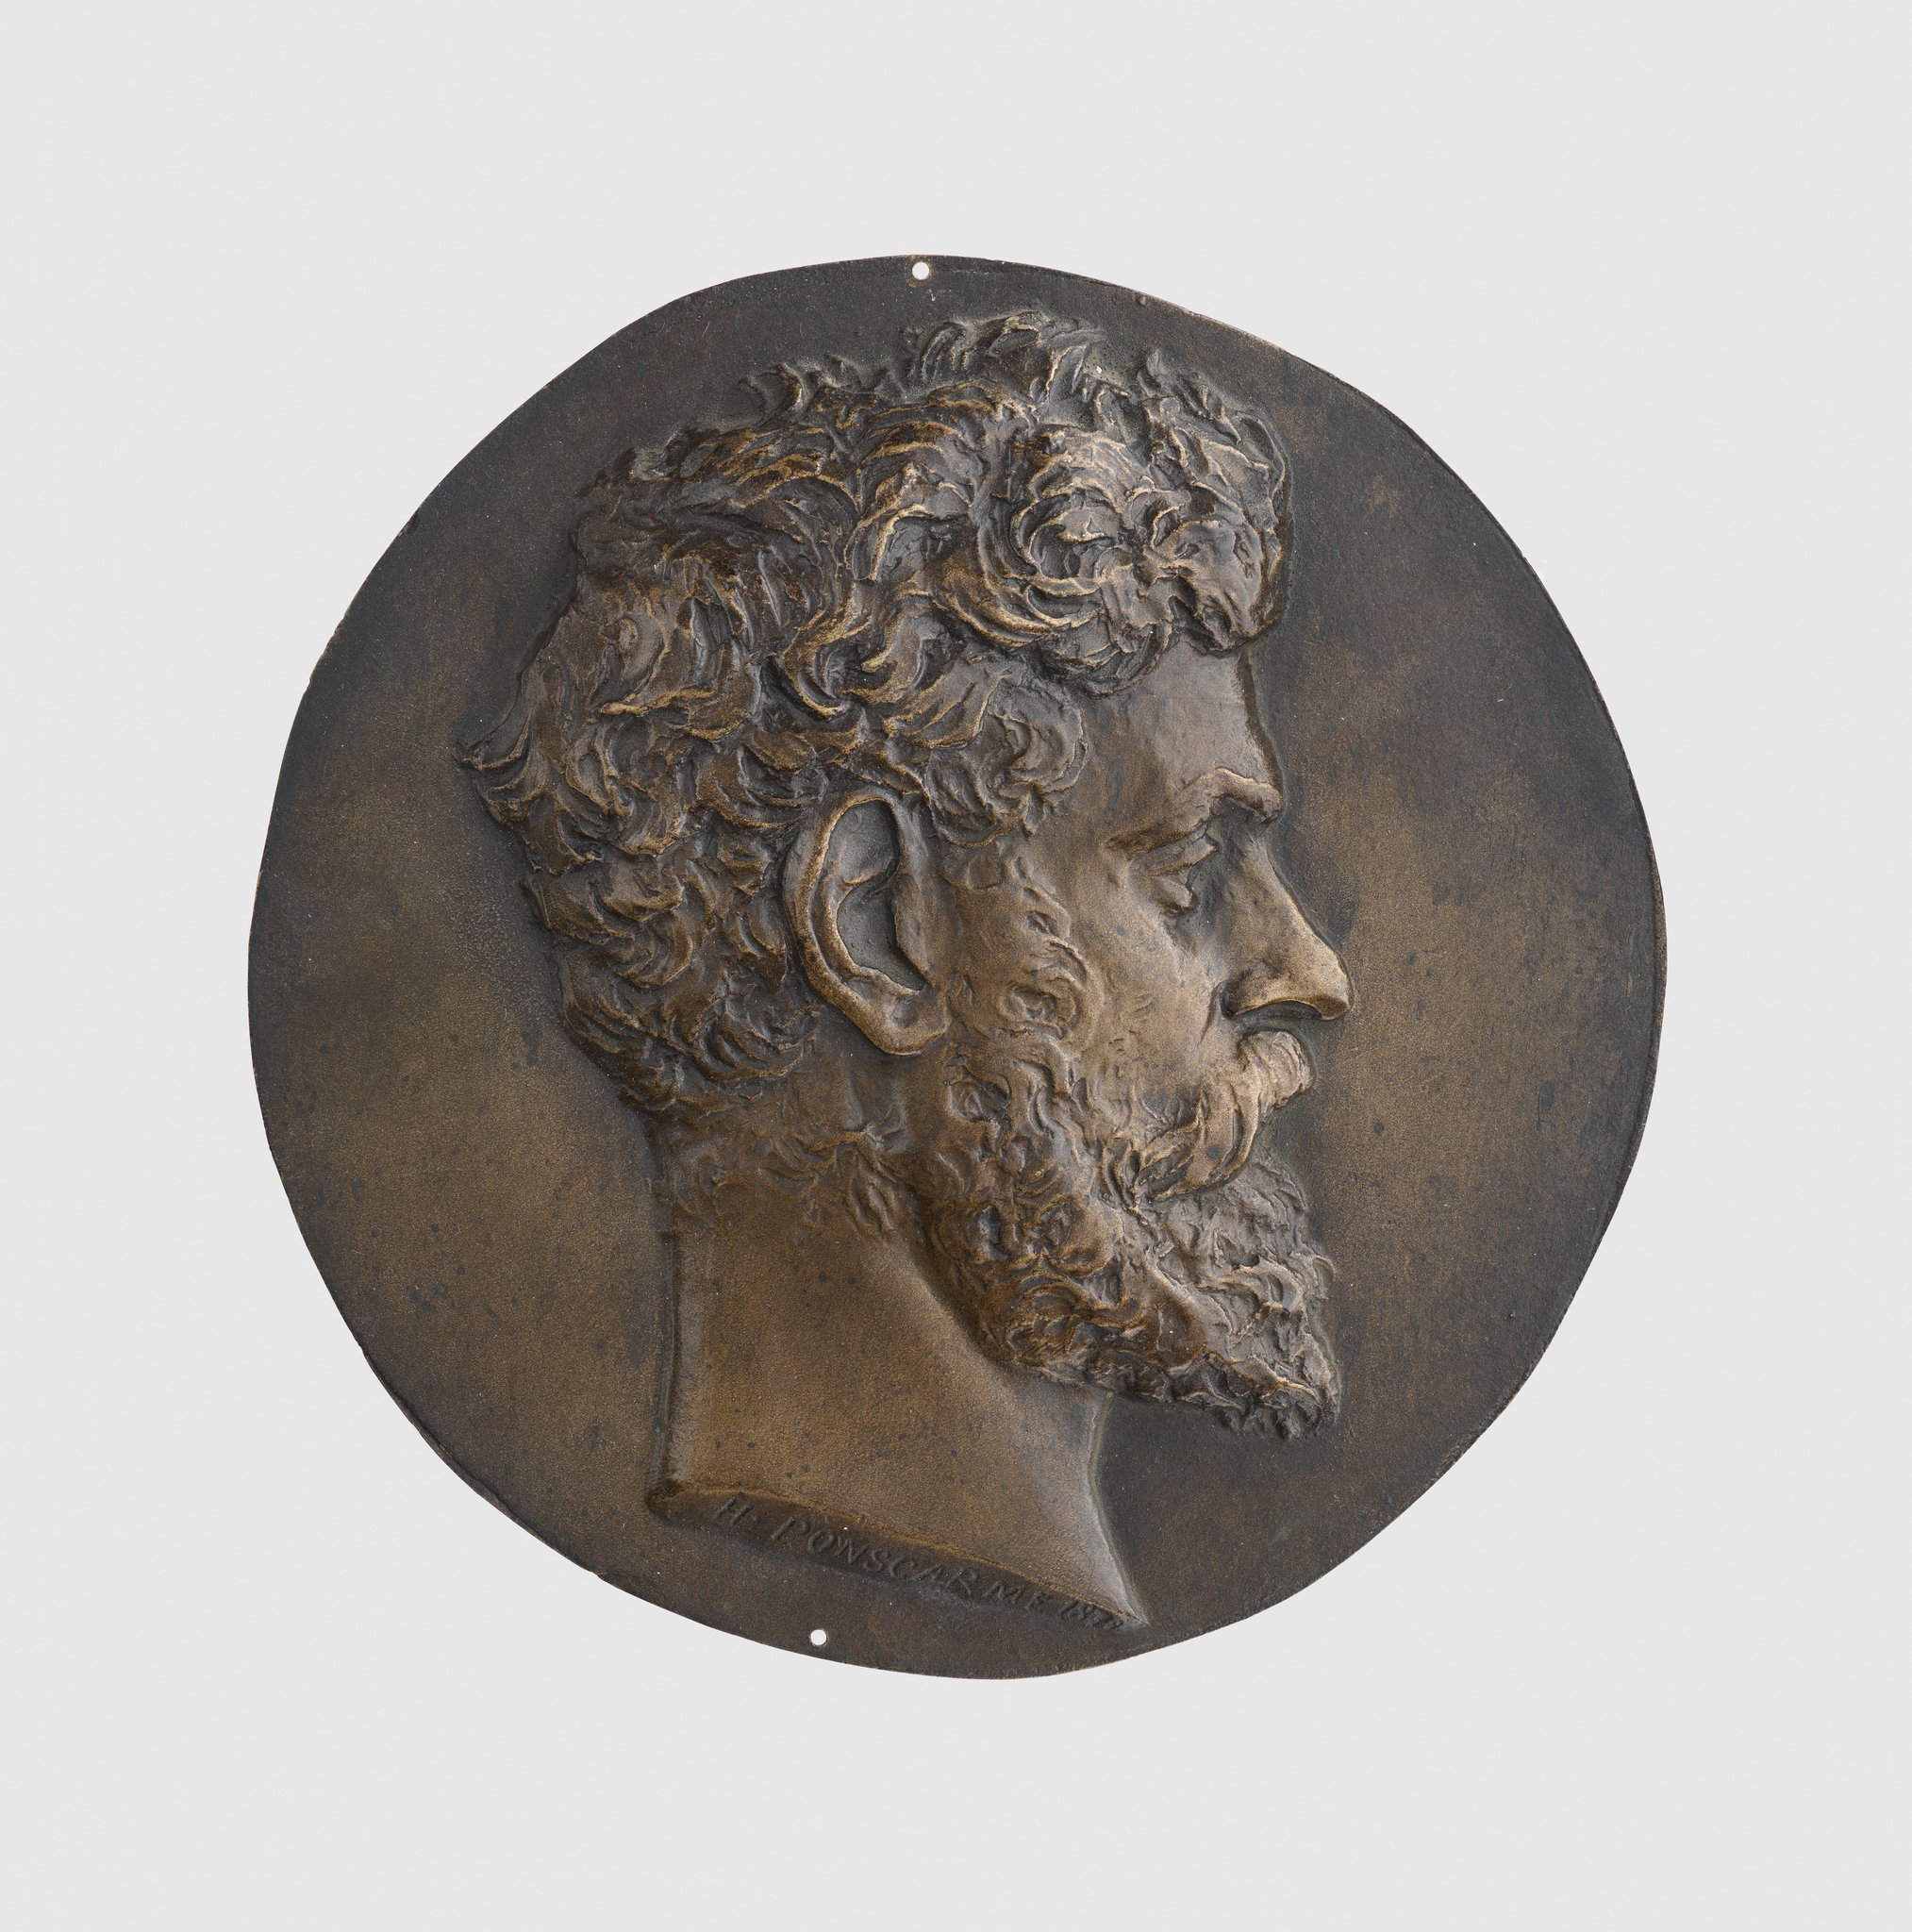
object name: medal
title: Self Portrait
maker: françois-joseph-hubert ponscarme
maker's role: maker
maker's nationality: french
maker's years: 1827-1903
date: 1871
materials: bronze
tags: men,self-portraits